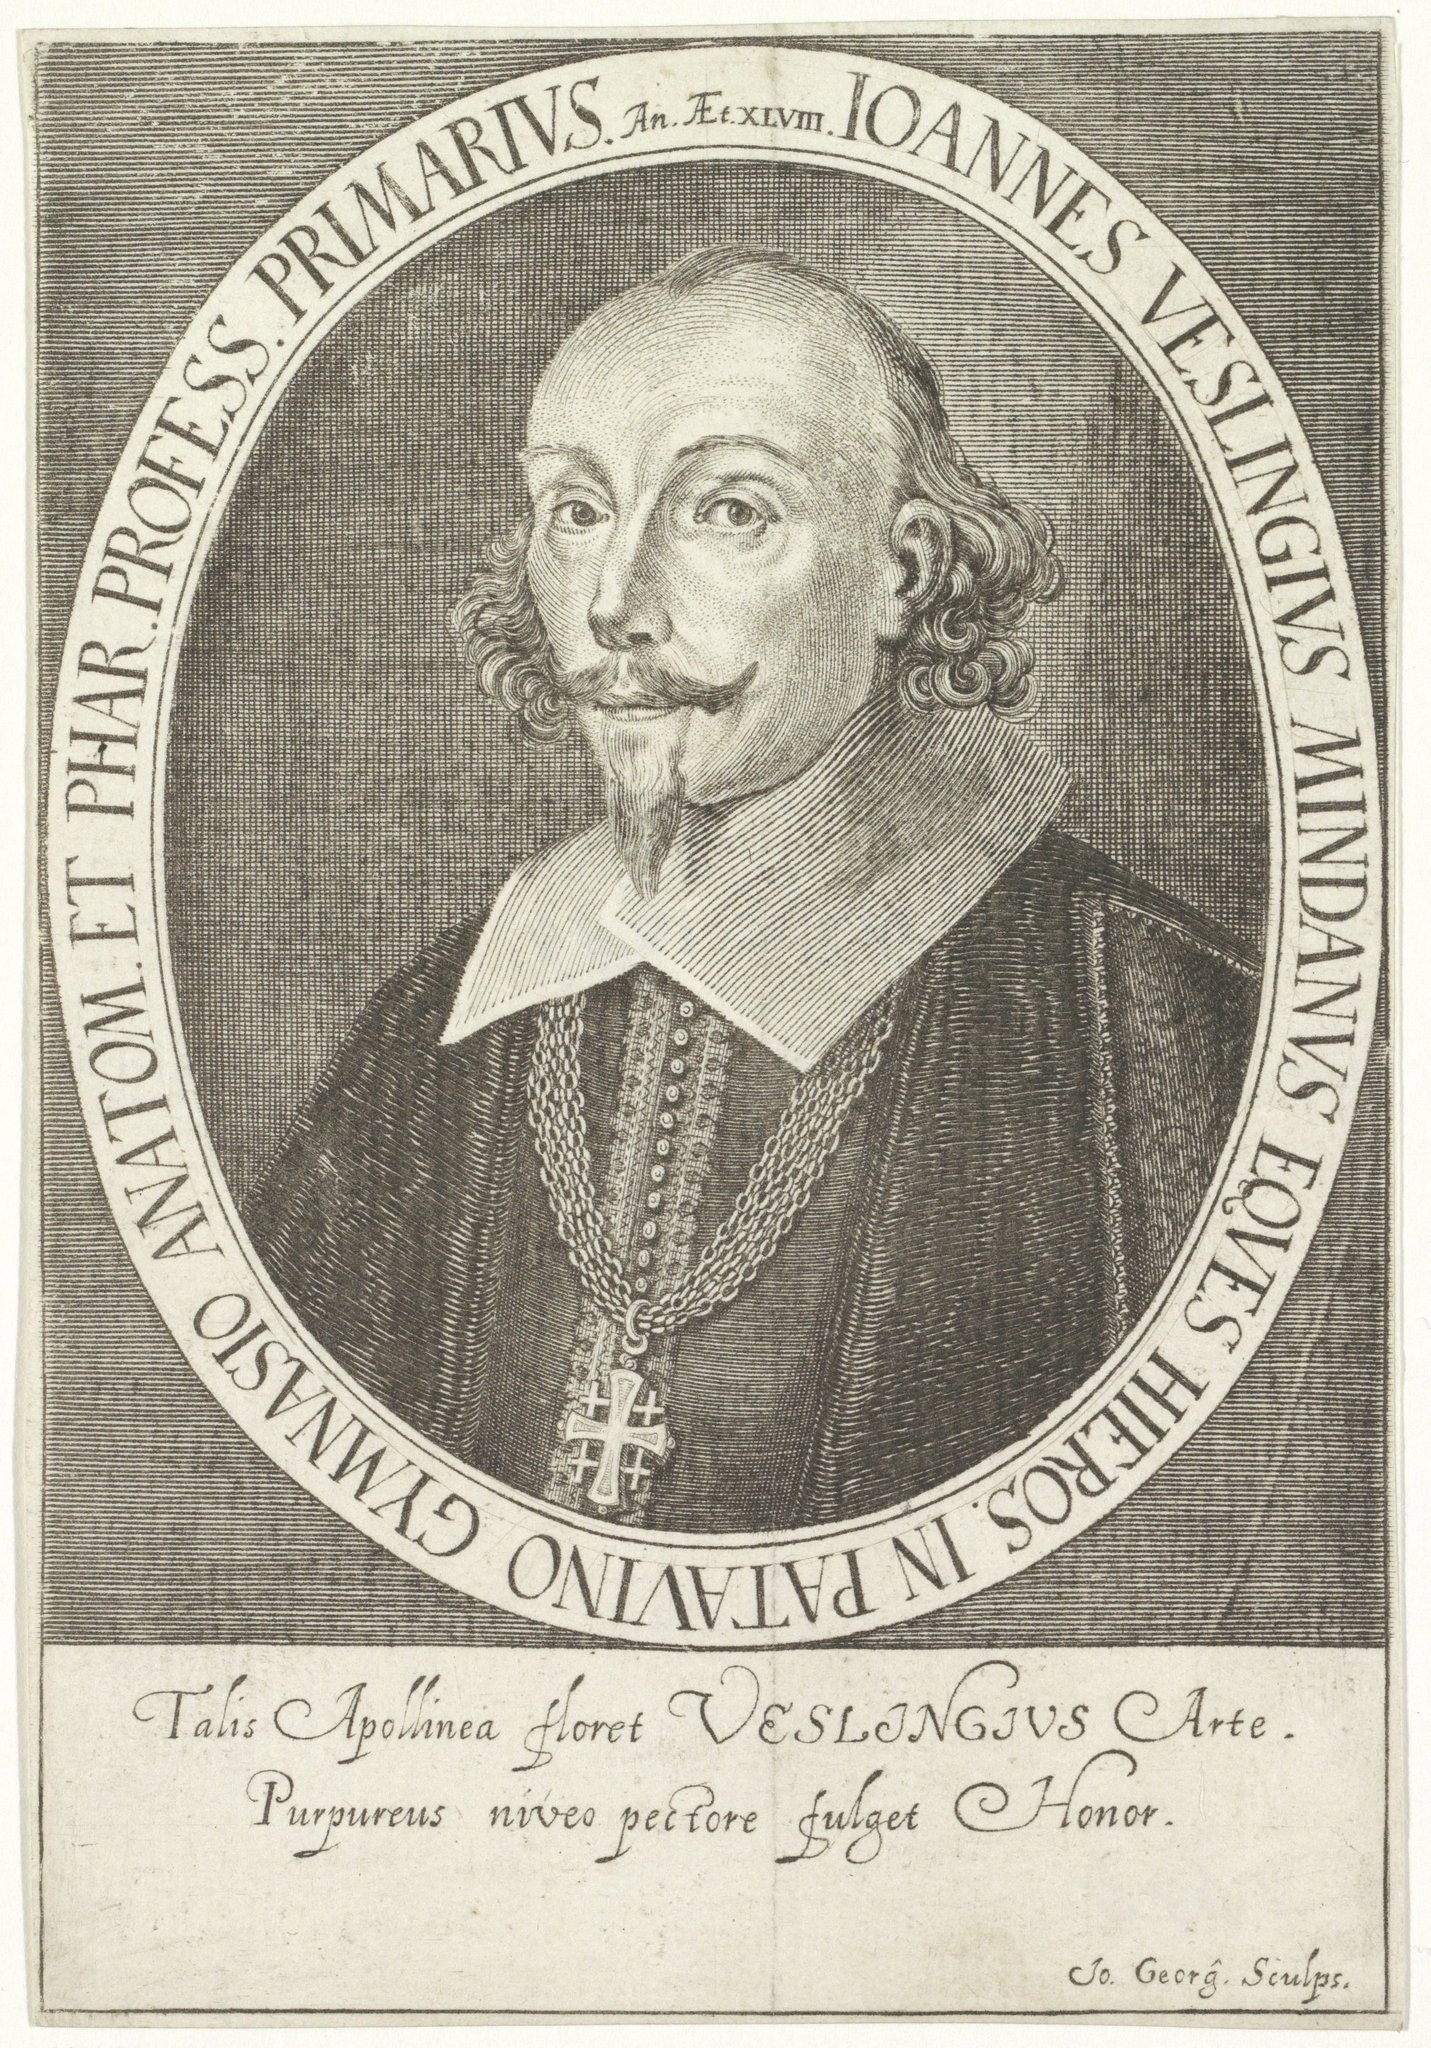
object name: print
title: Portret van Johannes Wesling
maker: giovanni georgi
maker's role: print maker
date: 1600-1699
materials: paper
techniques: engraving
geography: italy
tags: historical persons, physician, doctor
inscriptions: collector's mark: Lugt 2228